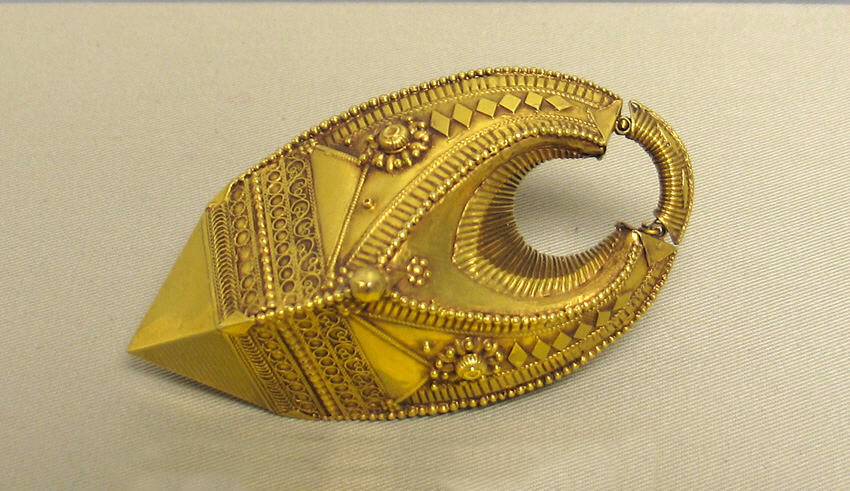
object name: pendant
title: Ear Pendant (Kathija)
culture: indian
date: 1801-1900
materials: gold